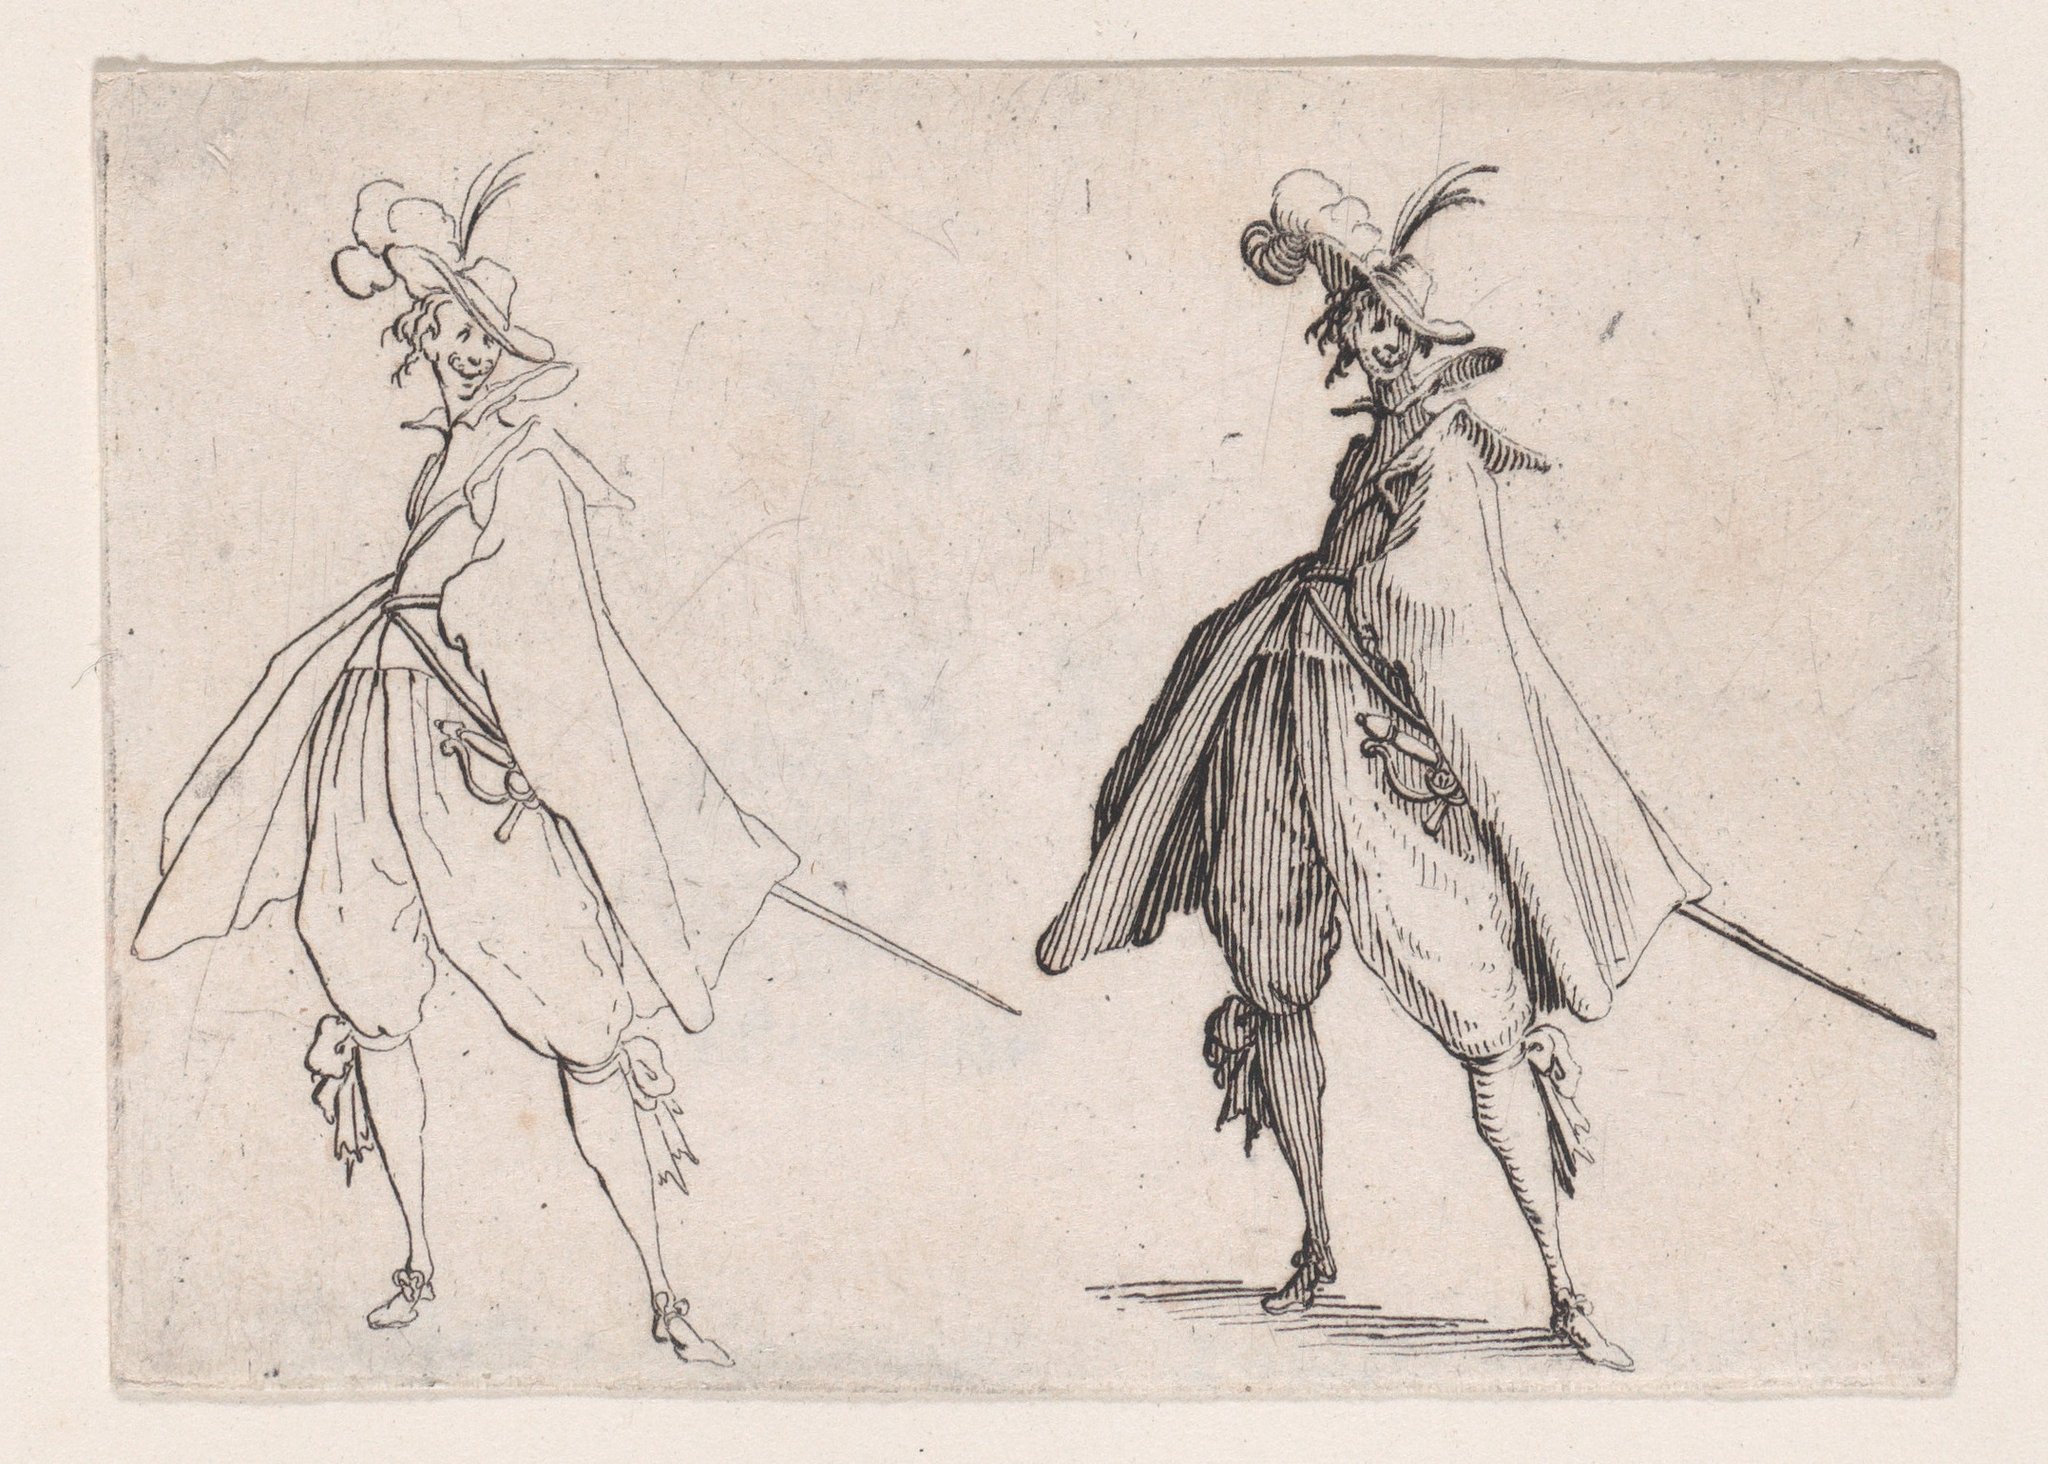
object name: print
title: Le Gentilhomme au Grand Manteau, Vu de Face (The Gentleman with a Large Mantle, Viewed from the Front), from "Les Caprices" Series A, The Florence Set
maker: jacques callot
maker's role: artist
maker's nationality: french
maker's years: 1592-1635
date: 1617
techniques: etching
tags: men